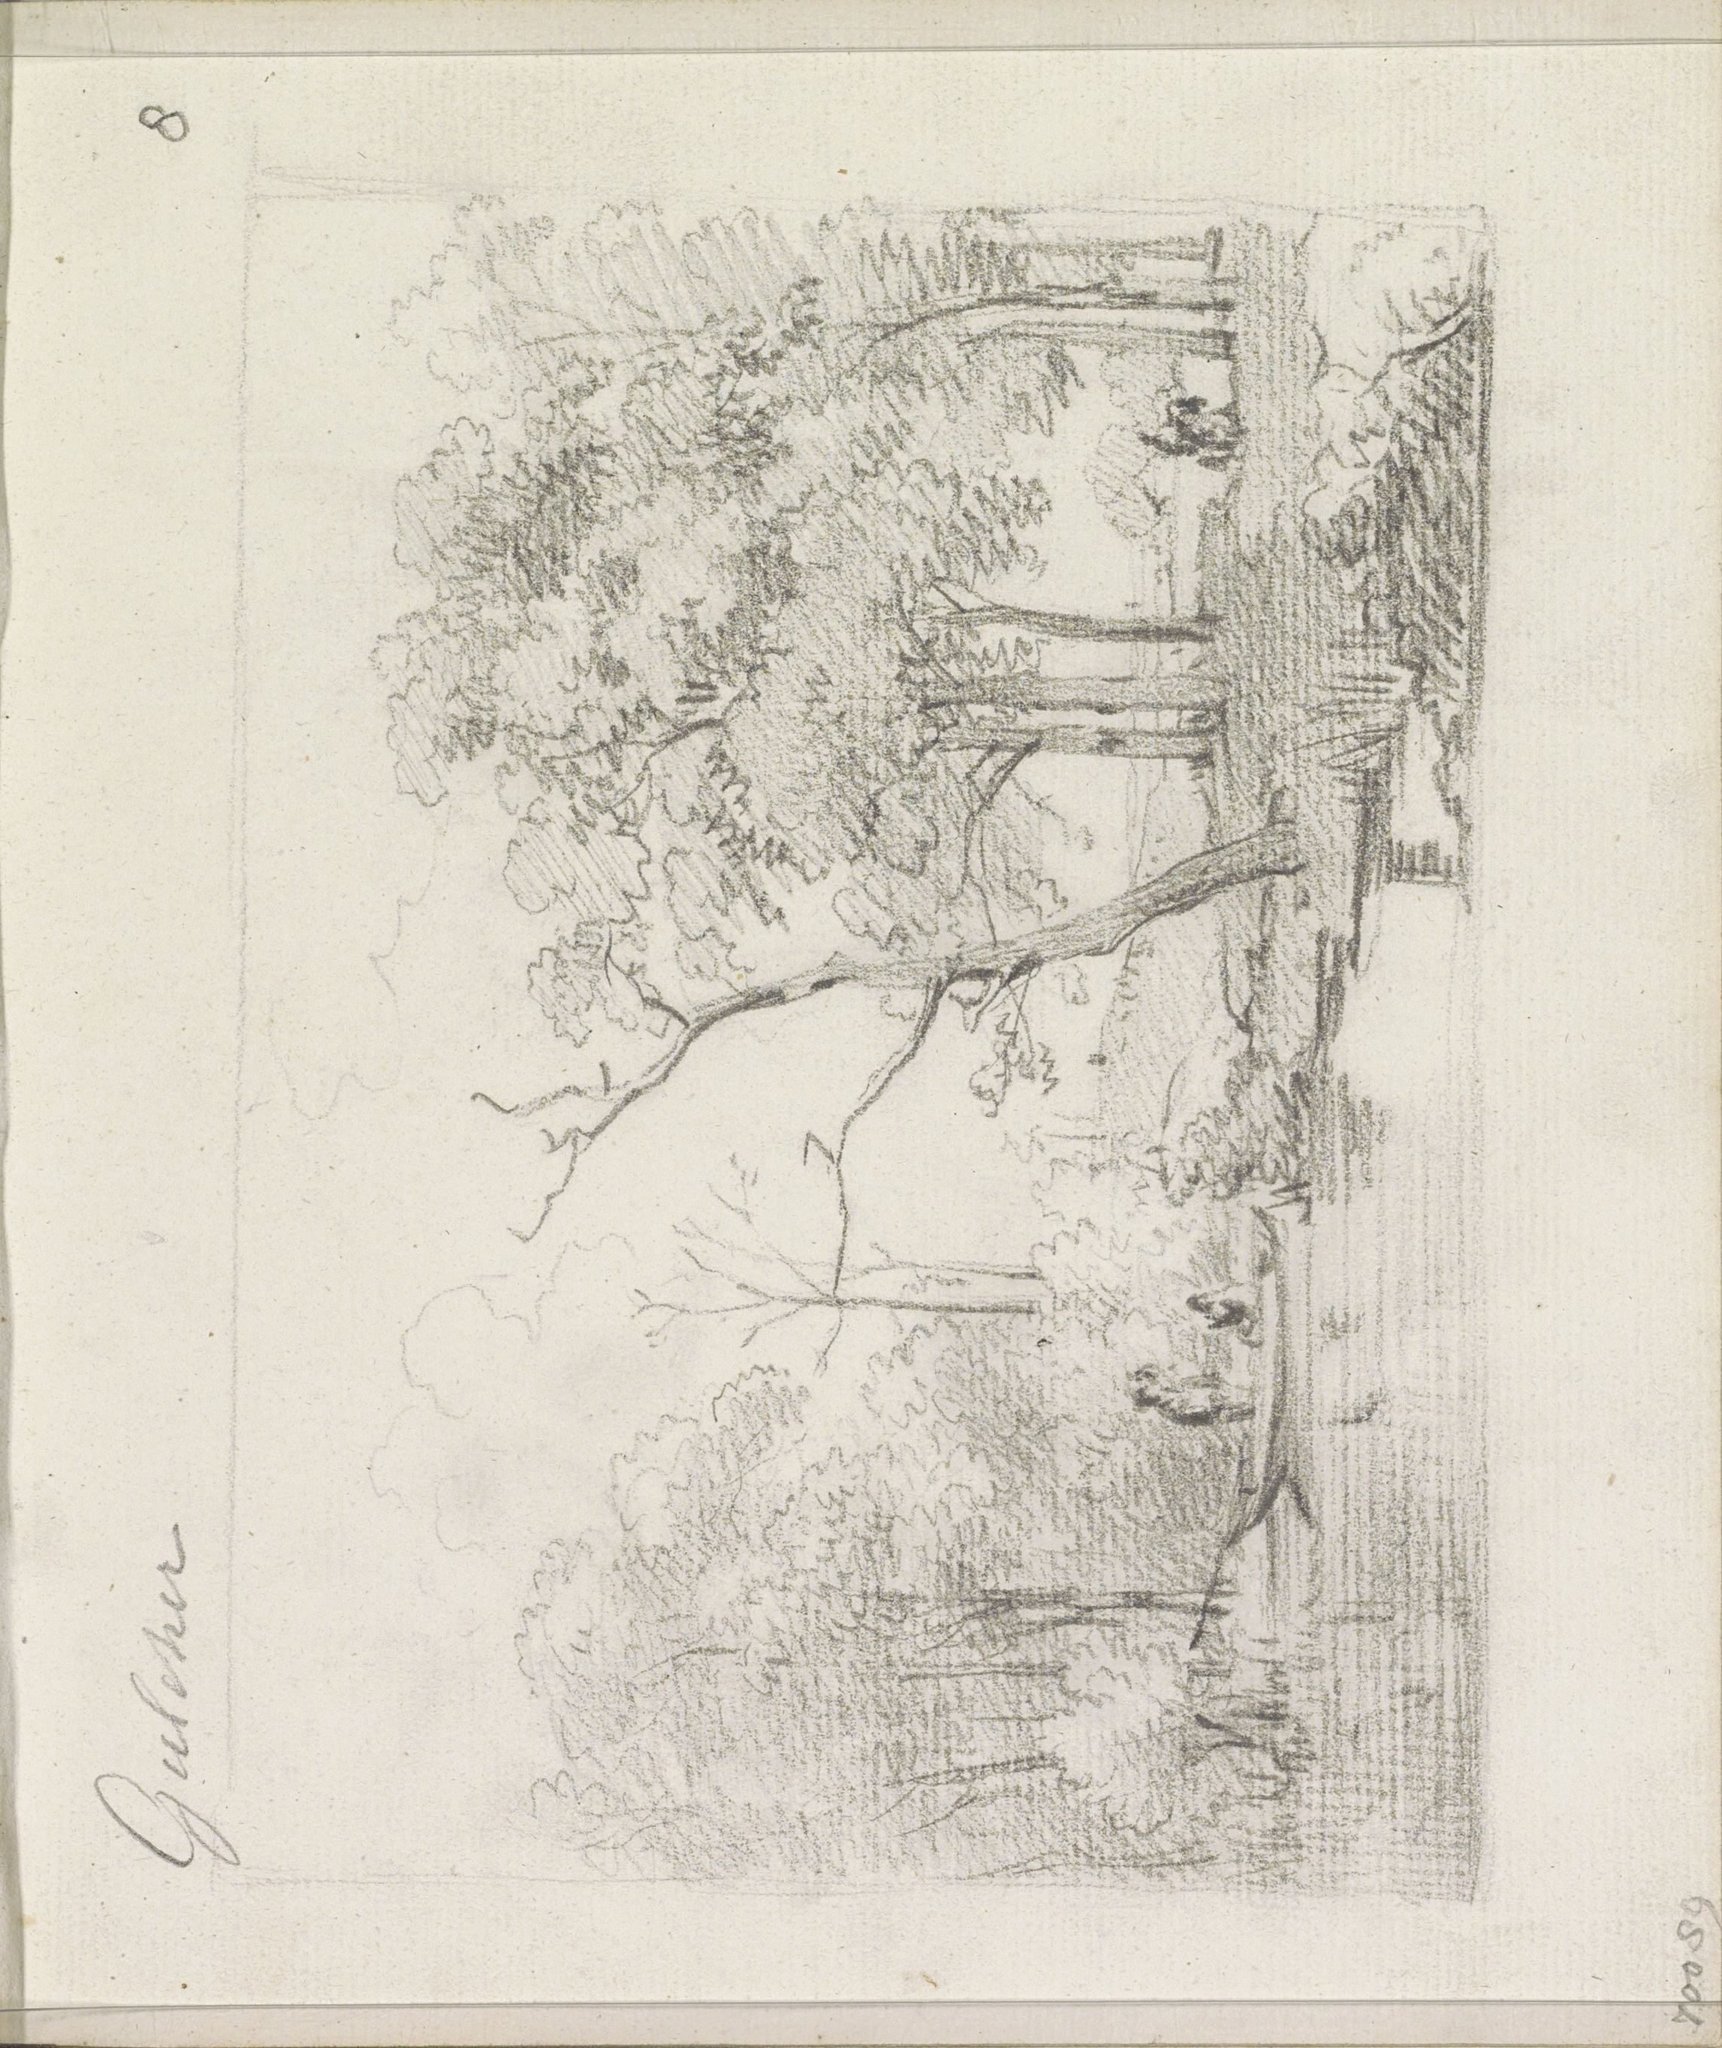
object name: sketchbook leaf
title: Landschap met figuren in een roeiboot op een rivier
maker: andreas schelfhout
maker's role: draughtsman, painter, print maker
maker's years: 1787-1870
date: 1825-1829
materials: chalk, paper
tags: rowing-boat, canoe, etc., landscapes with waters, waterscapes, seascapes (in the temperate zone) (+ landscape with figures, staffage)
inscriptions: annotation: ‘Gulsker’, number: ‘8/ 70089’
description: Blad 22 recto uit een schetsboek met 95 bladen.